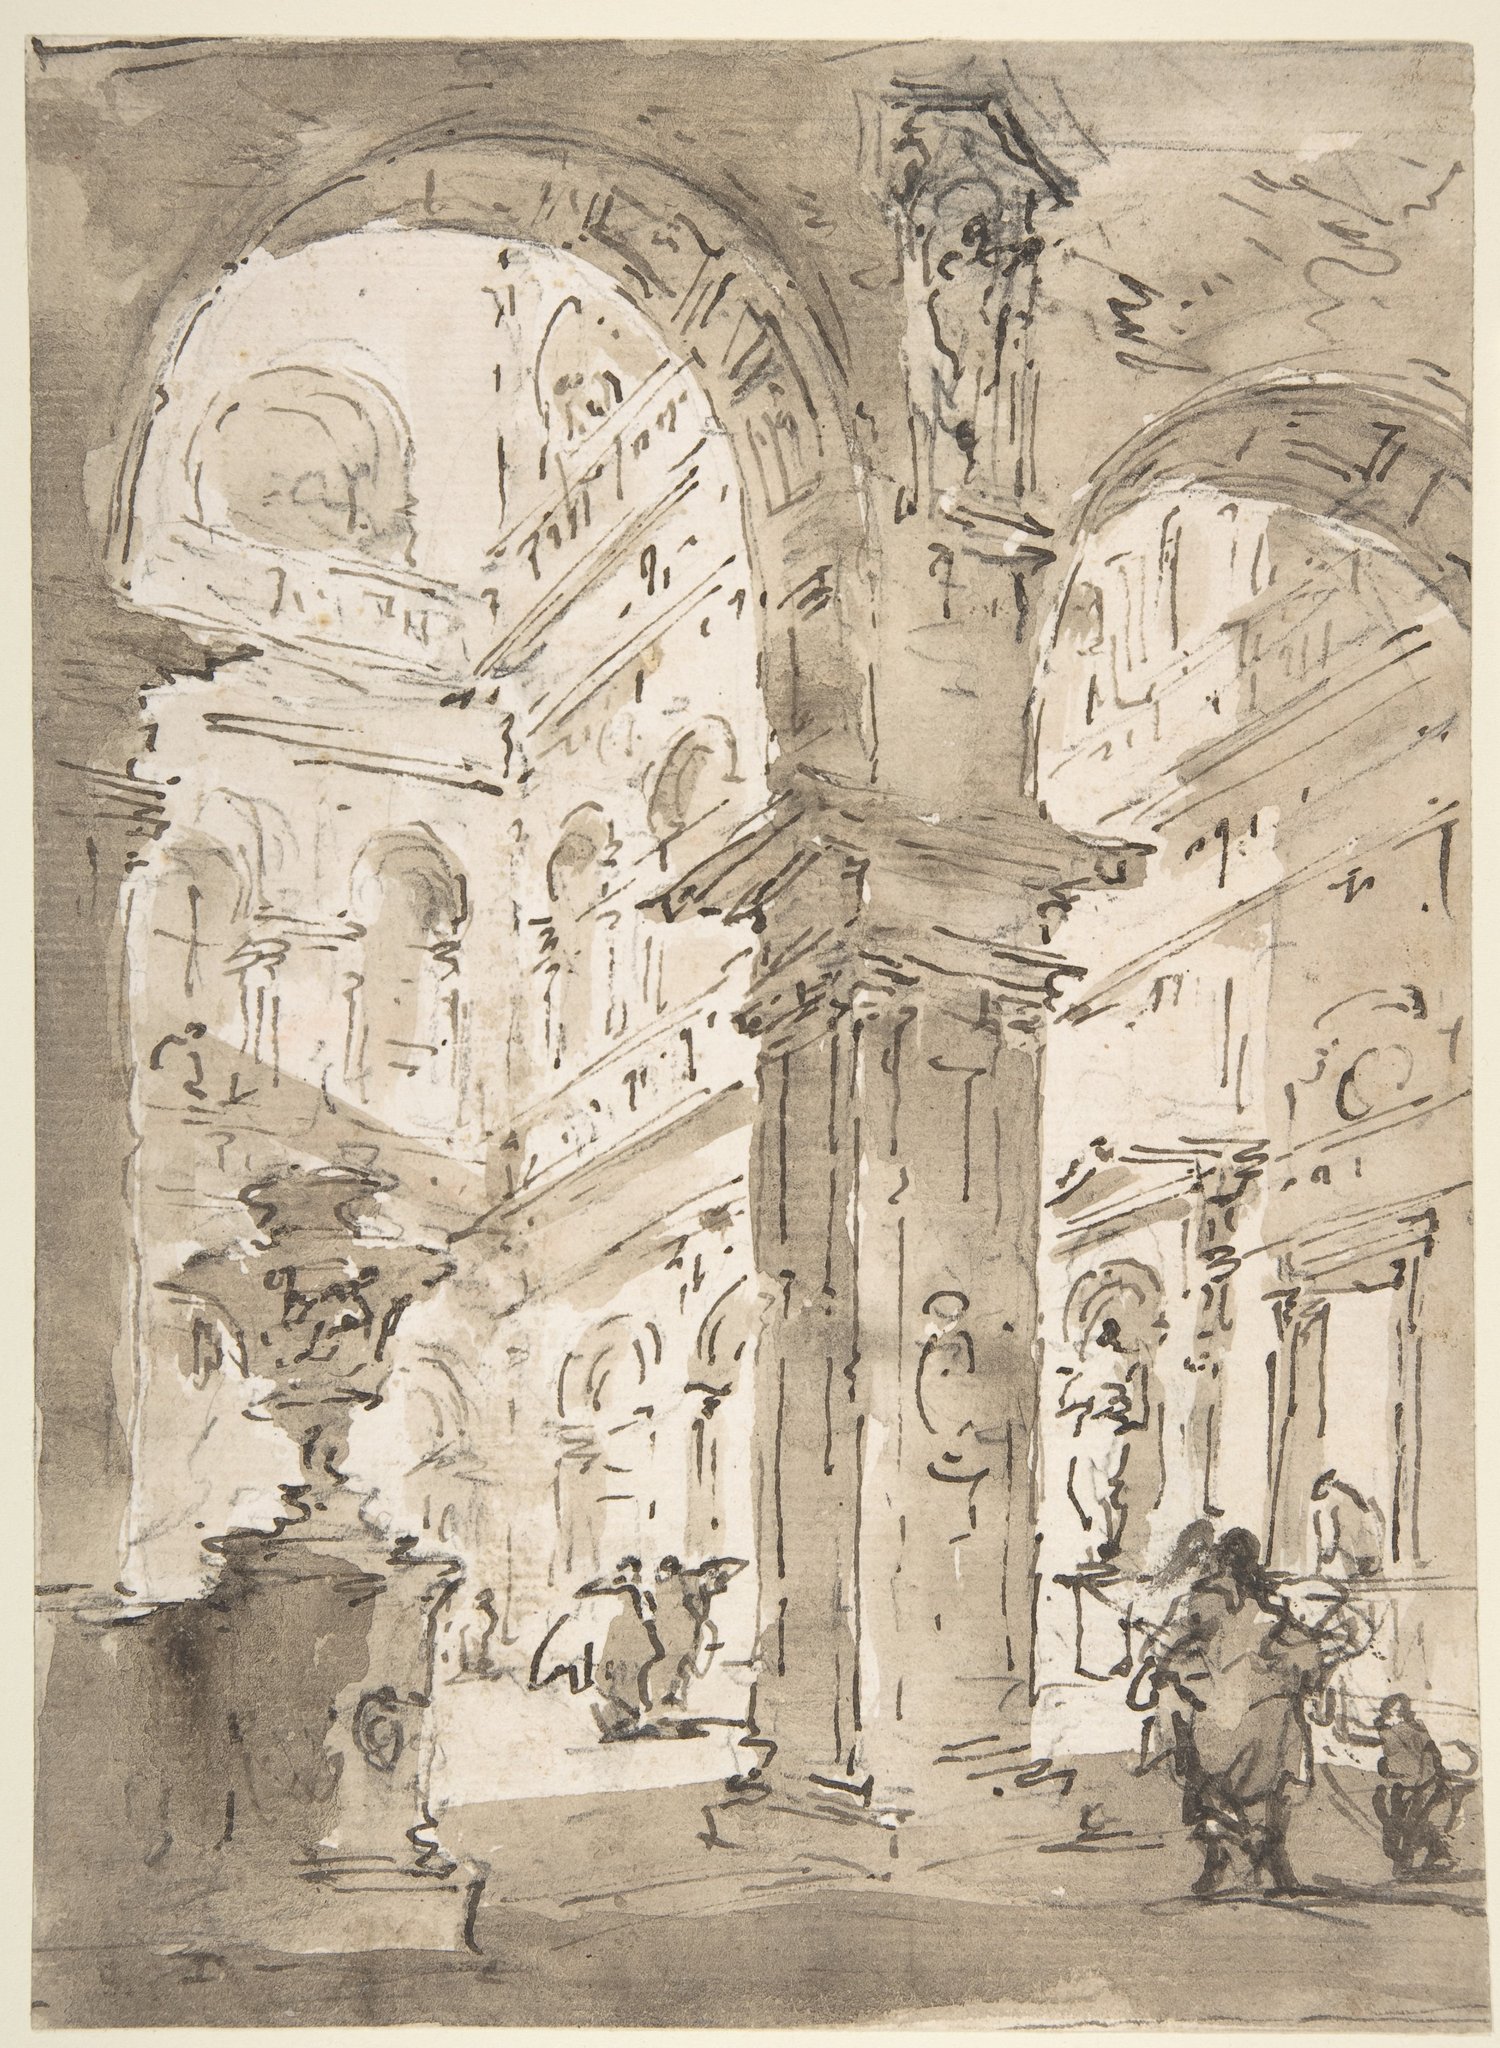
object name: drawing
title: Architectural Capriccio: Courtyard of a Palace (recto); Saint Aloysius Gonzaga Holding a Crucifix (verso)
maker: francesco guardi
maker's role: artist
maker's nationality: italian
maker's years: 1712-1793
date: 1712-1793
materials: chalk, graphite, ink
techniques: brush, pen, wash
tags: courtyards,saints